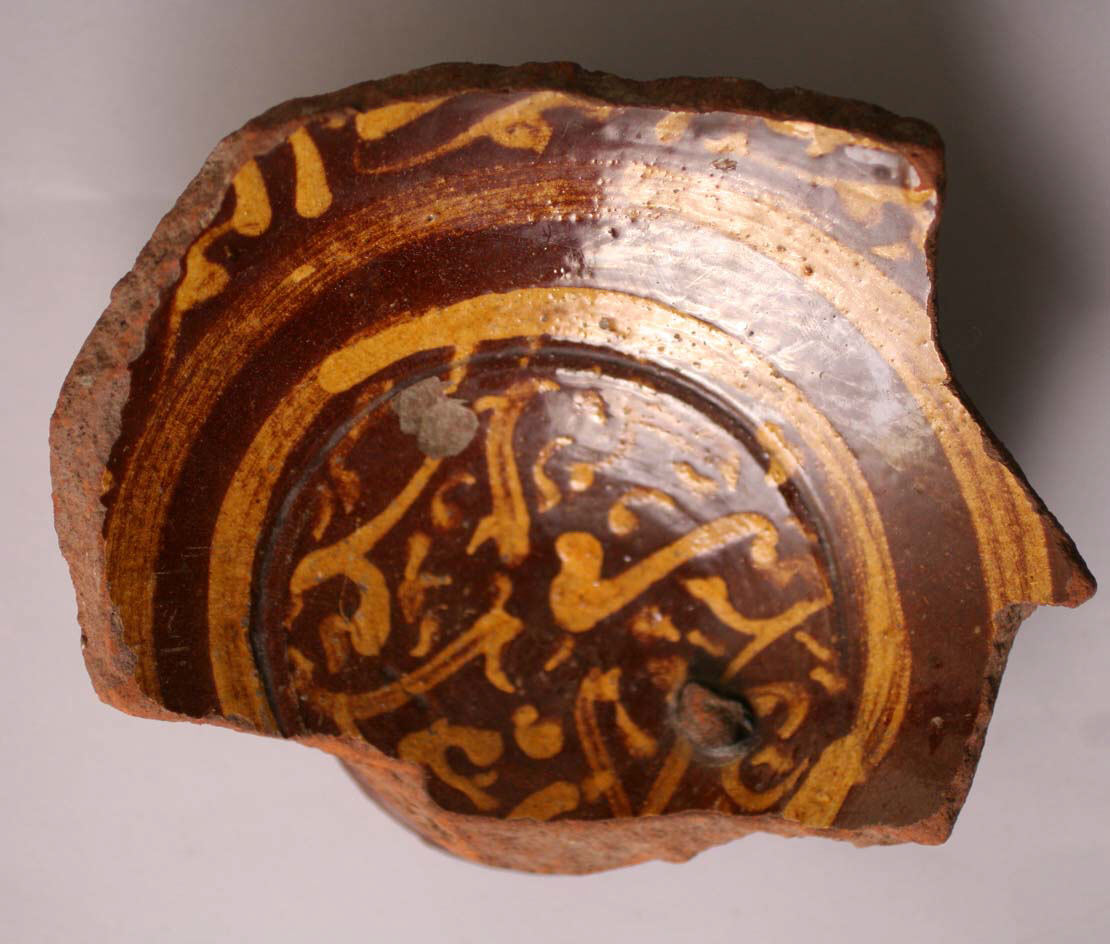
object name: ceramic fragment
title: Fragment of a Bowl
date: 1301-1500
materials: earthenware, glaze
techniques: painting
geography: egypt